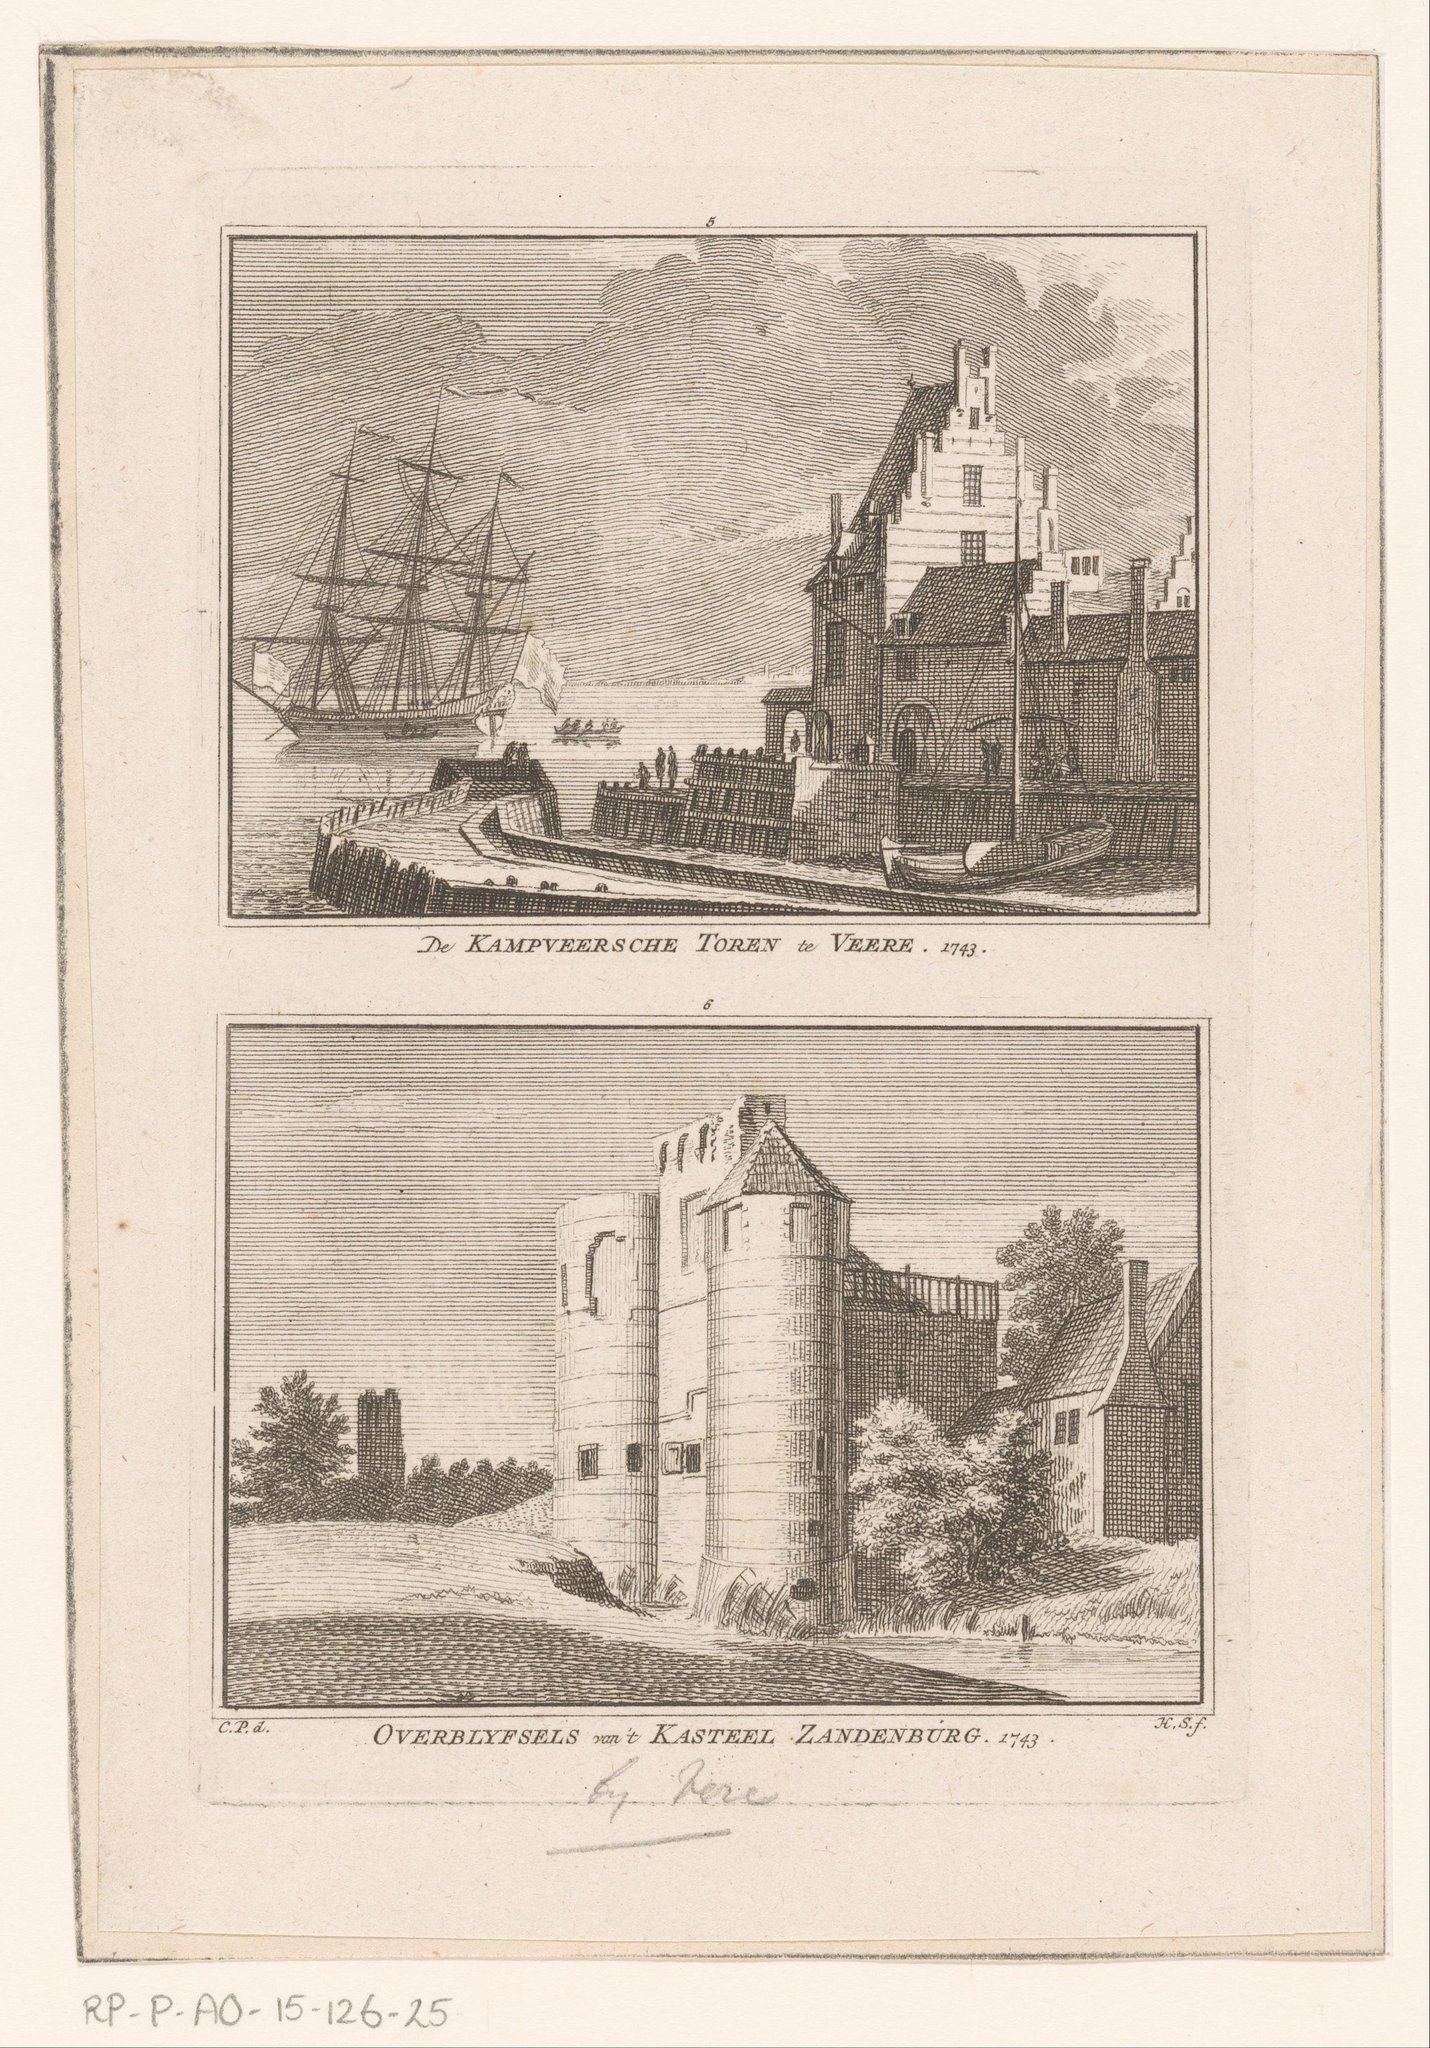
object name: print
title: De Kampveersche Toren te Veere. 1743 / Overblyfsels van 't Kasteel Zandenburg. 1743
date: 1754-1792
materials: paper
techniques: etching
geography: haarlem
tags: castle, towers ~ fortified city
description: Prent ook gebruikt in: Het verheerlykt Nederland of kabinet van hedendaagsche gezigten van steden, dorpen (…). 9 delen. Amsterdam: Isaak Tirion en weduwe Isaak Tirion, 1745-1774, dl. 5 (1754), ill. 5-6. Of in: Nederlandsche tafereelen; of eene keurige verzameling van negen honderd fraaije gezigten van steden, dorpen, sloten, oudheden [….]. 9 delen. Amsterdam: Jan de Groot, 1792, dl. 5, ill. 5-6.